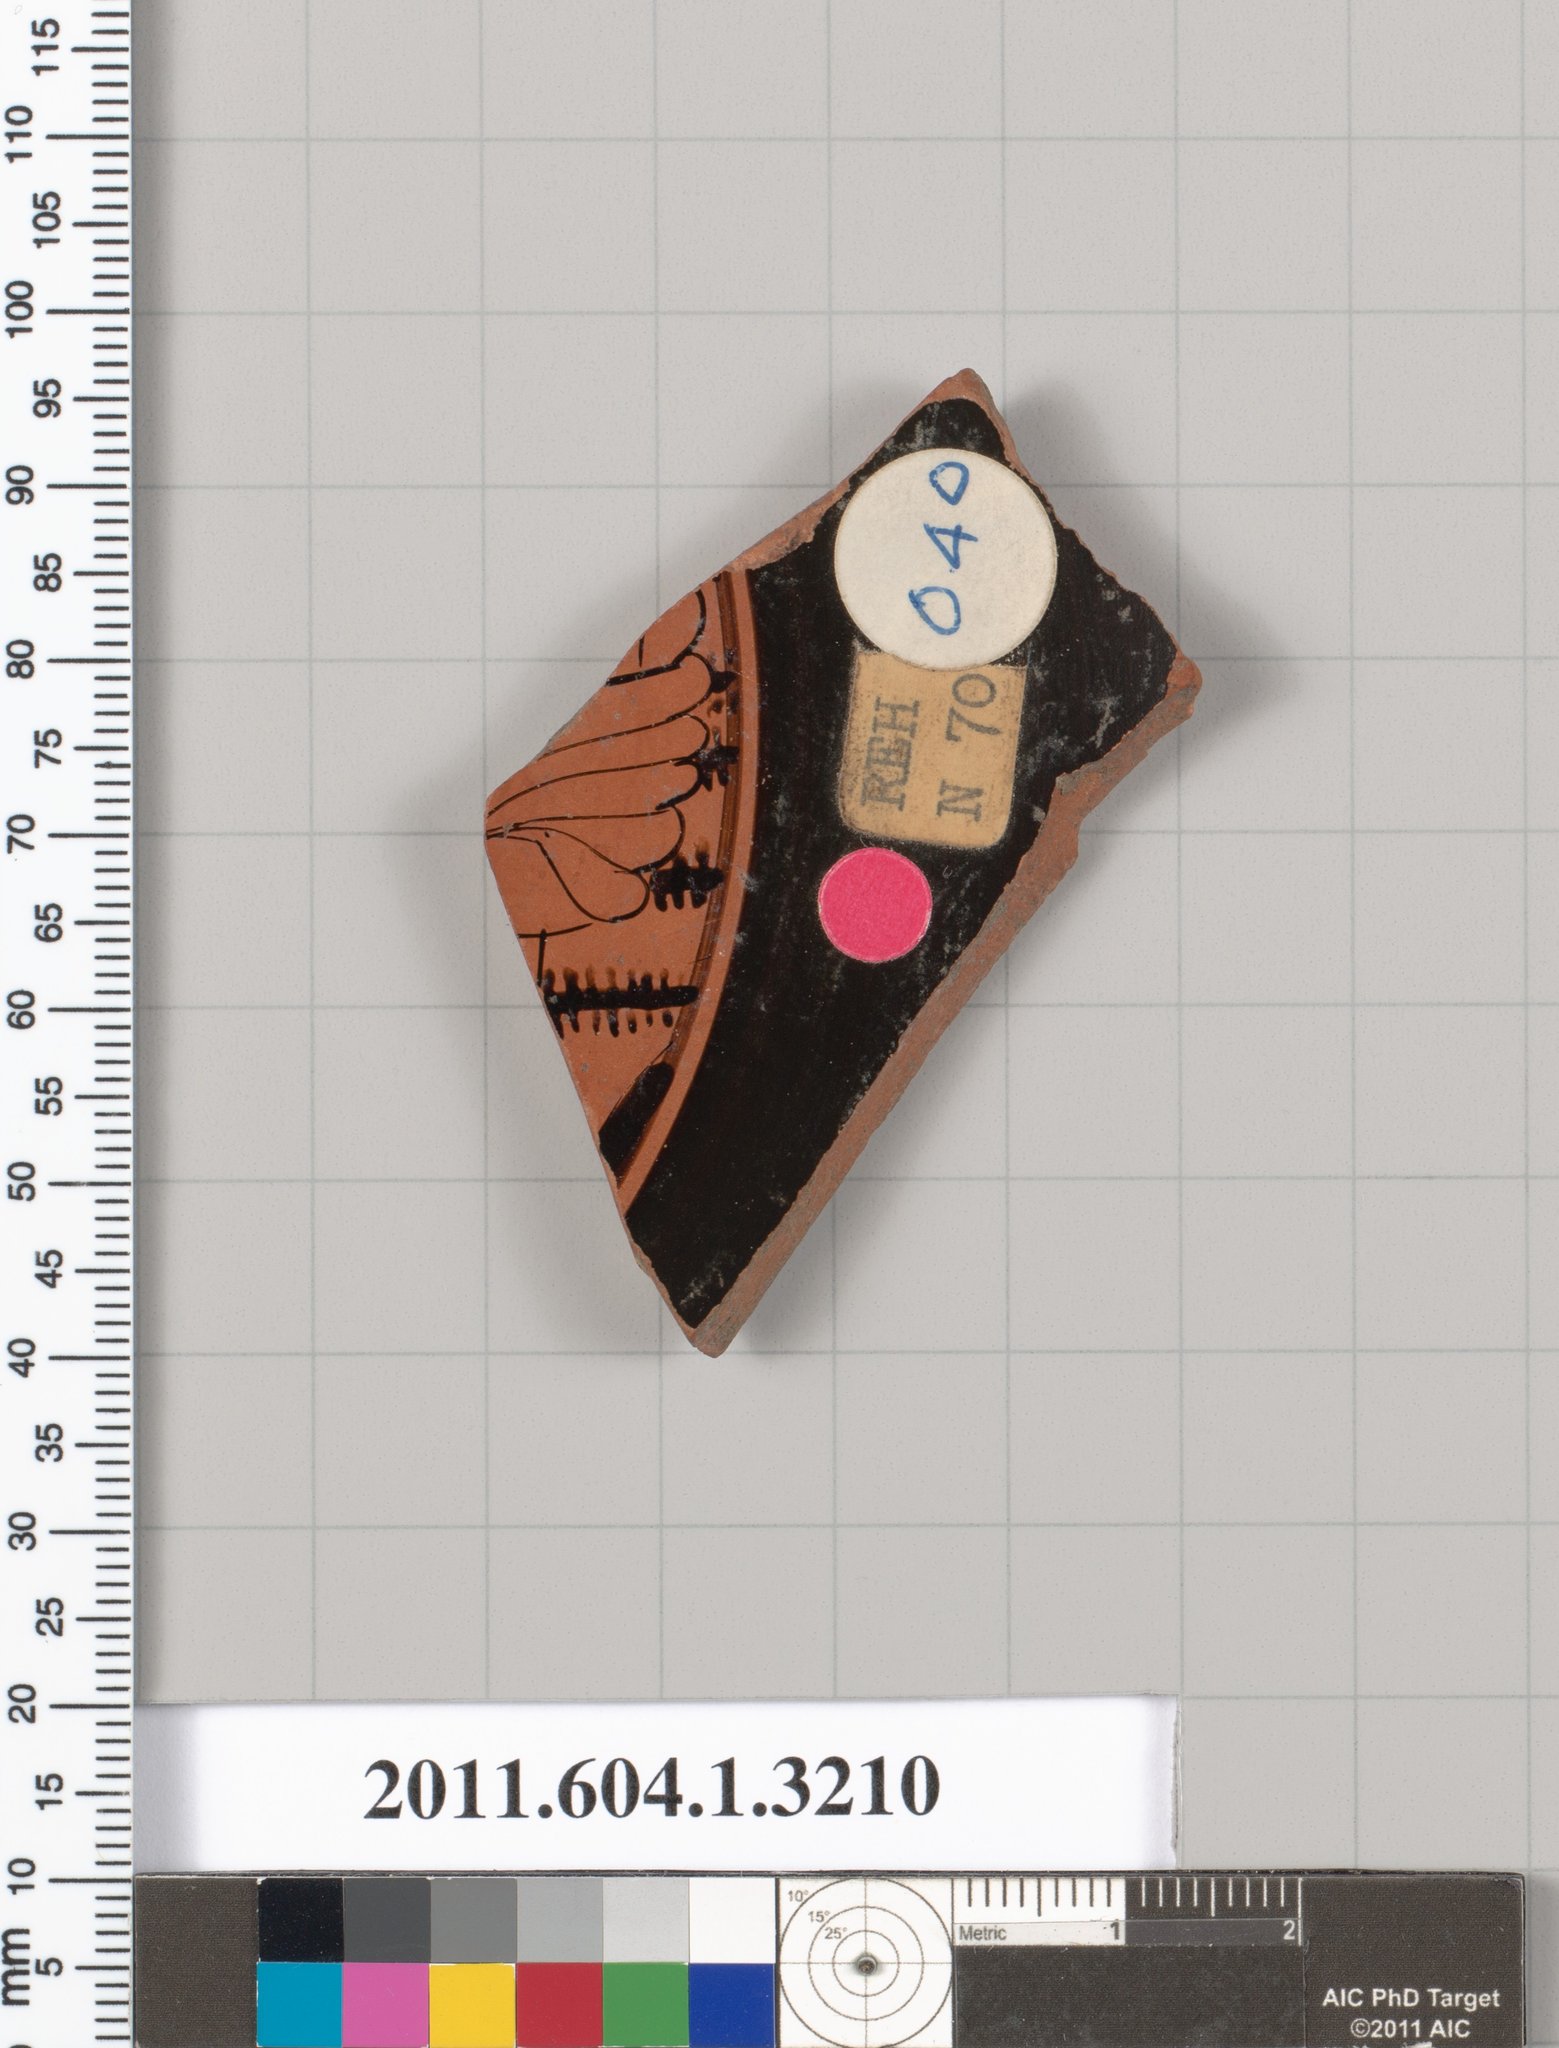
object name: kylix fragment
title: Terracotta fragment of a kylix (drinking cup)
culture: greek, attic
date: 500-490 BCE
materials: terracotta